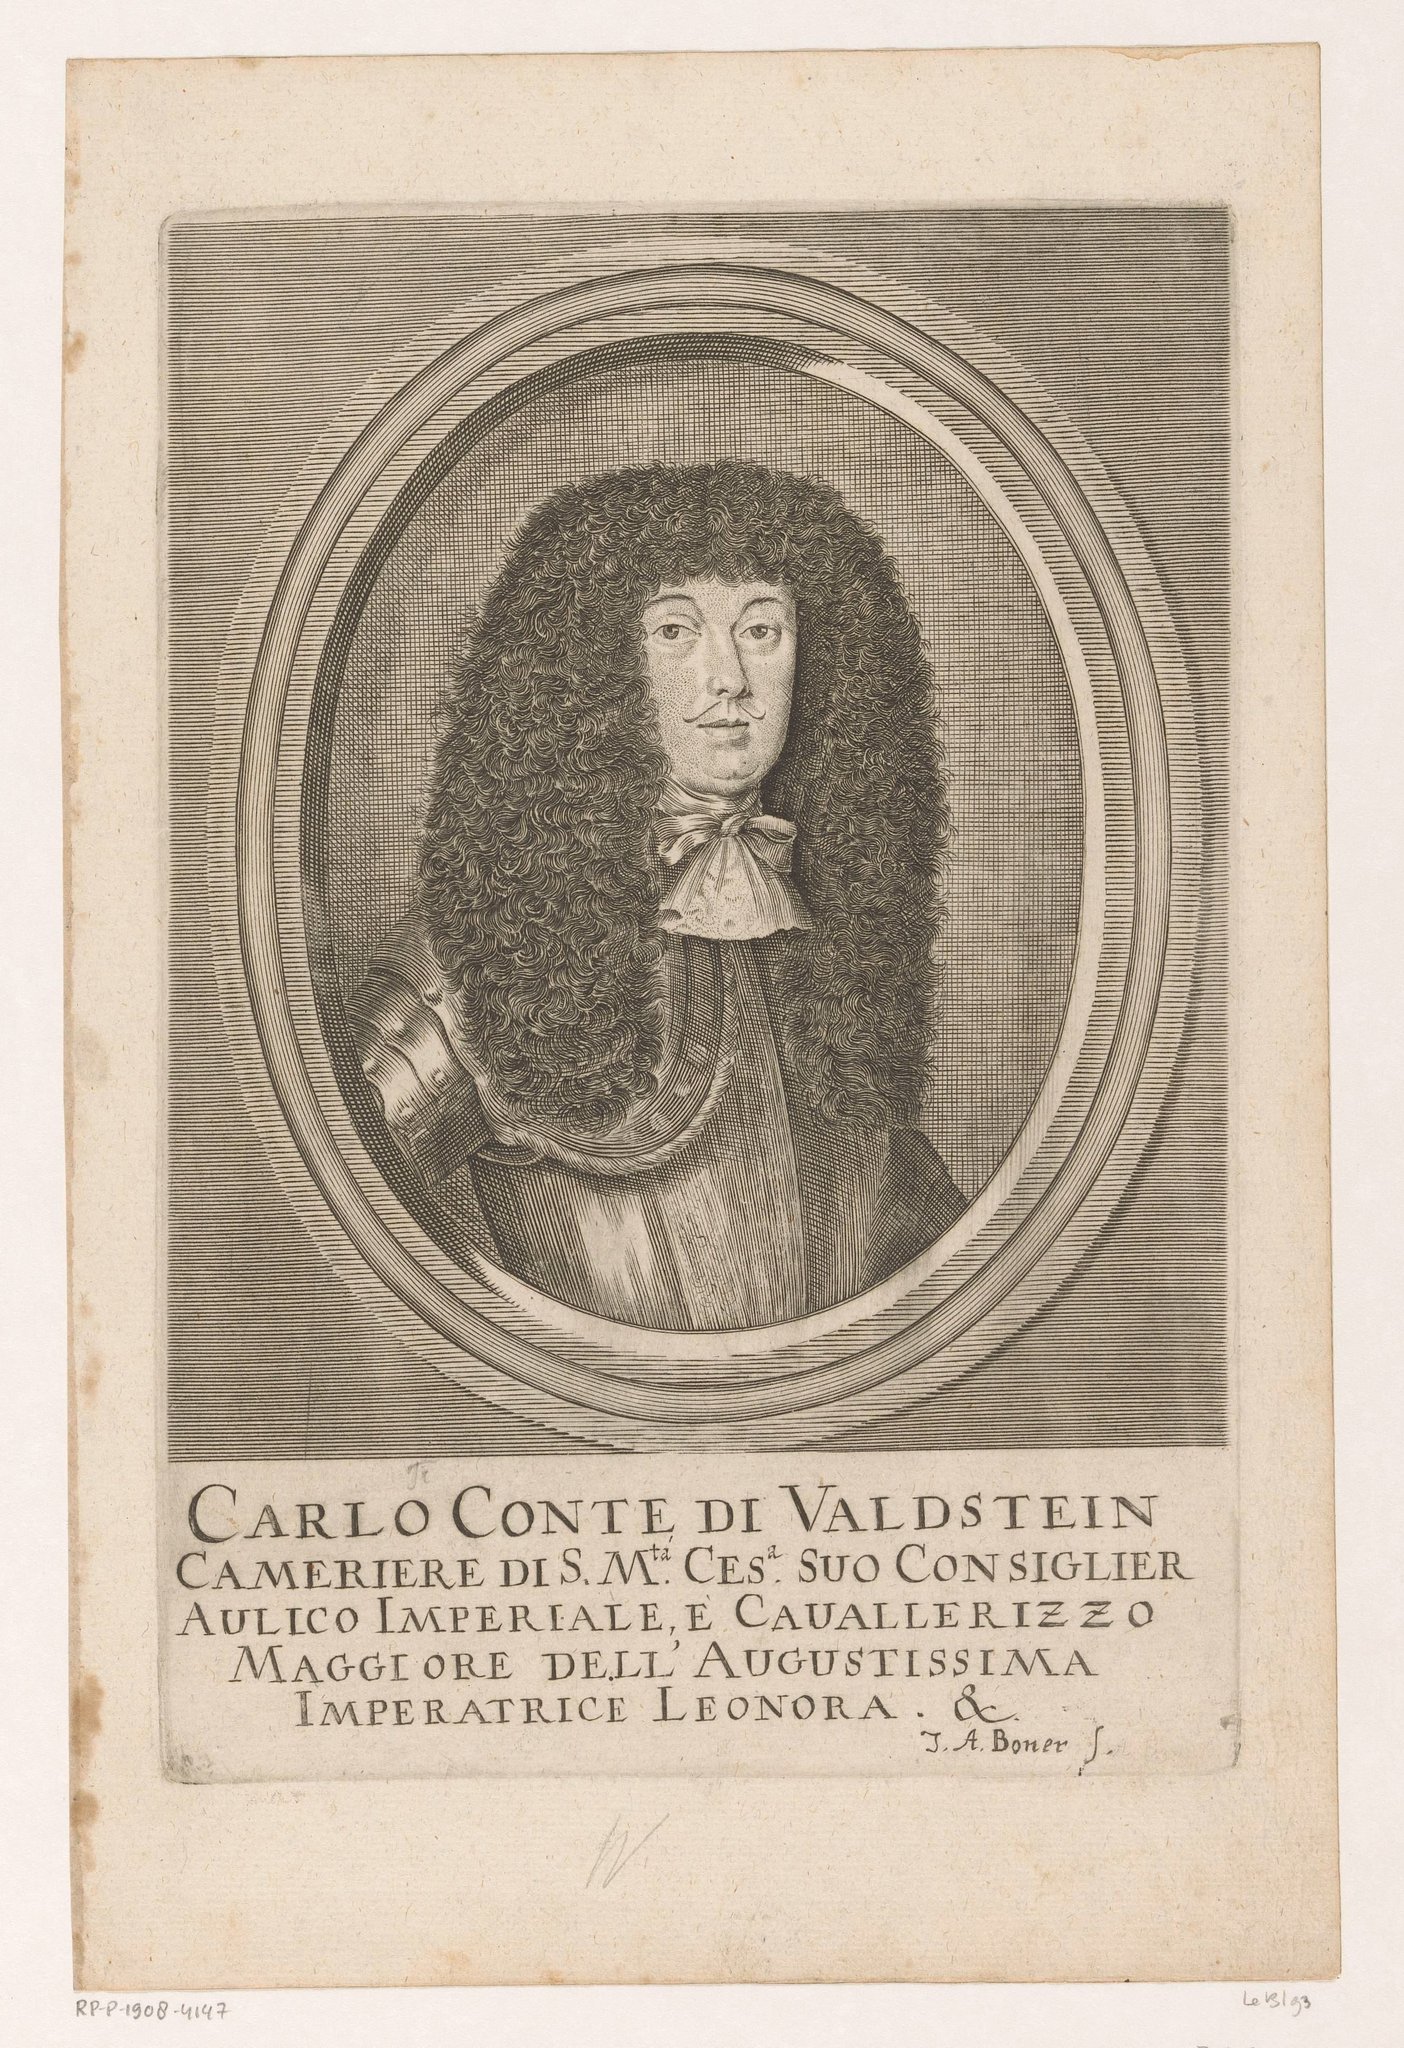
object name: print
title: Portret van Carl Ferdinand, Graf von Waldstein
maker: johann alexander böner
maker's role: draughtsman, print maker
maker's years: 1647-1720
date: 1674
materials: paper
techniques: engraving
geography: nuremberg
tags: armour, historical persons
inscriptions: collector's mark: Lugt 2228